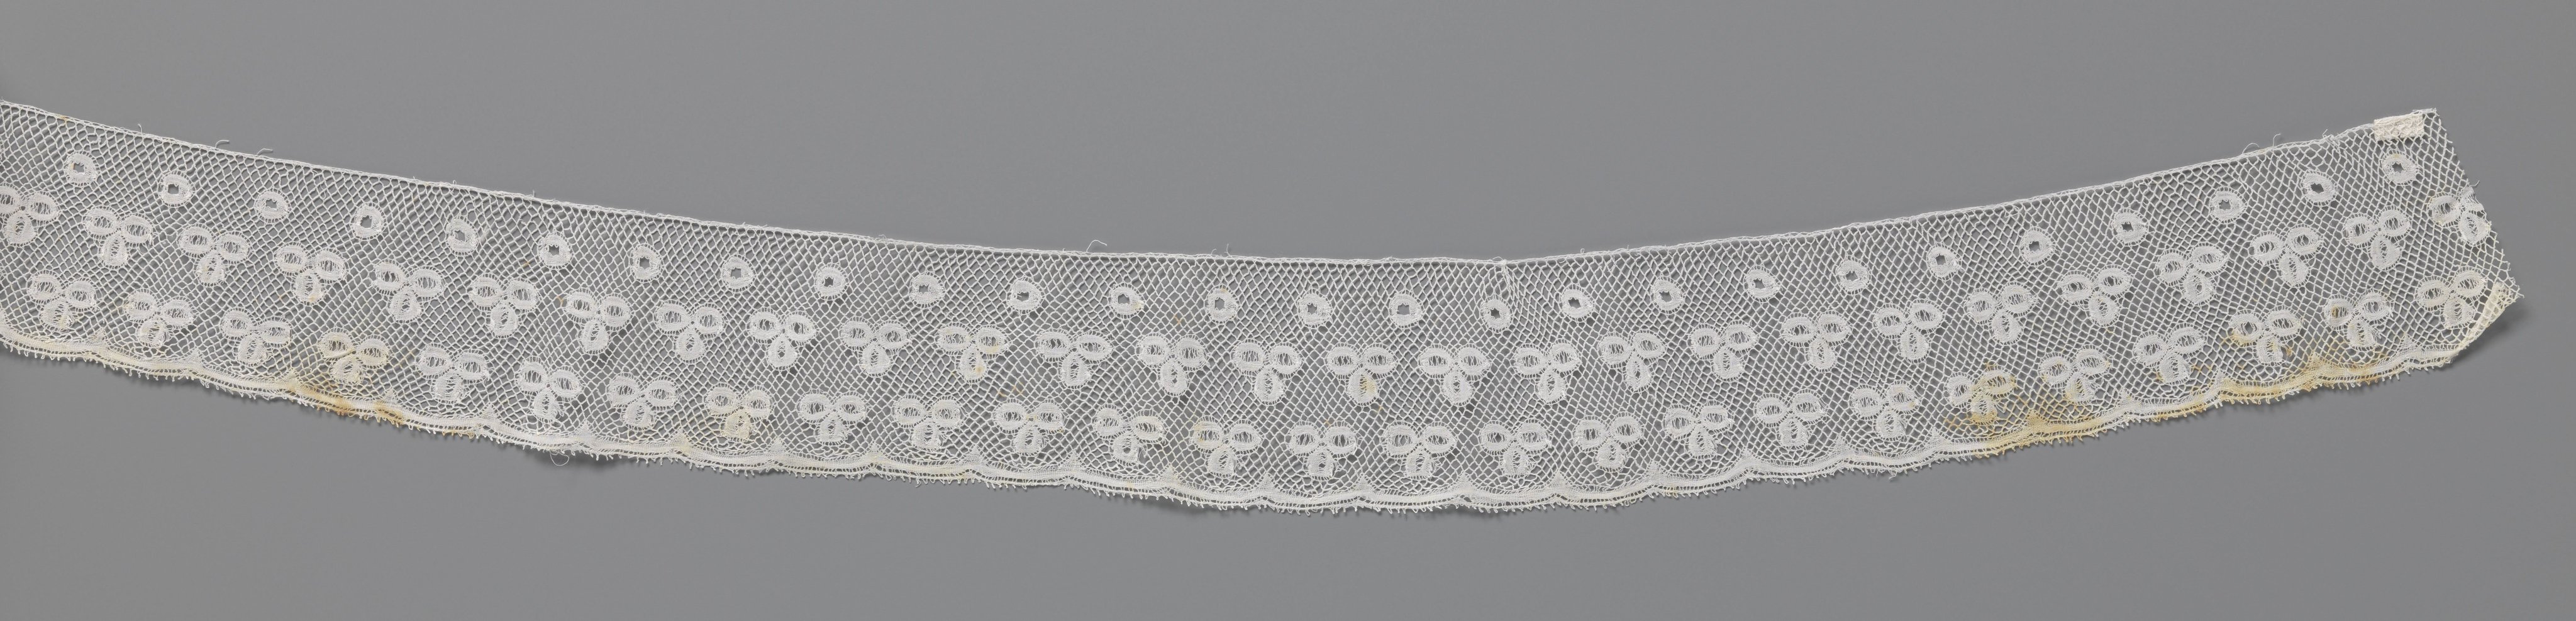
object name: strip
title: Strook kloskant met klaverblaadjes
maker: Anonymous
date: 1910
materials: linen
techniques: lace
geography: netherlands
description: Op een grof mazenfond (vierkante maas) staat een rij van 'pailletten' en twee rijen van klaverblaadjes. De schulpjes zijn vlak en glad. Valenciennes-kant.